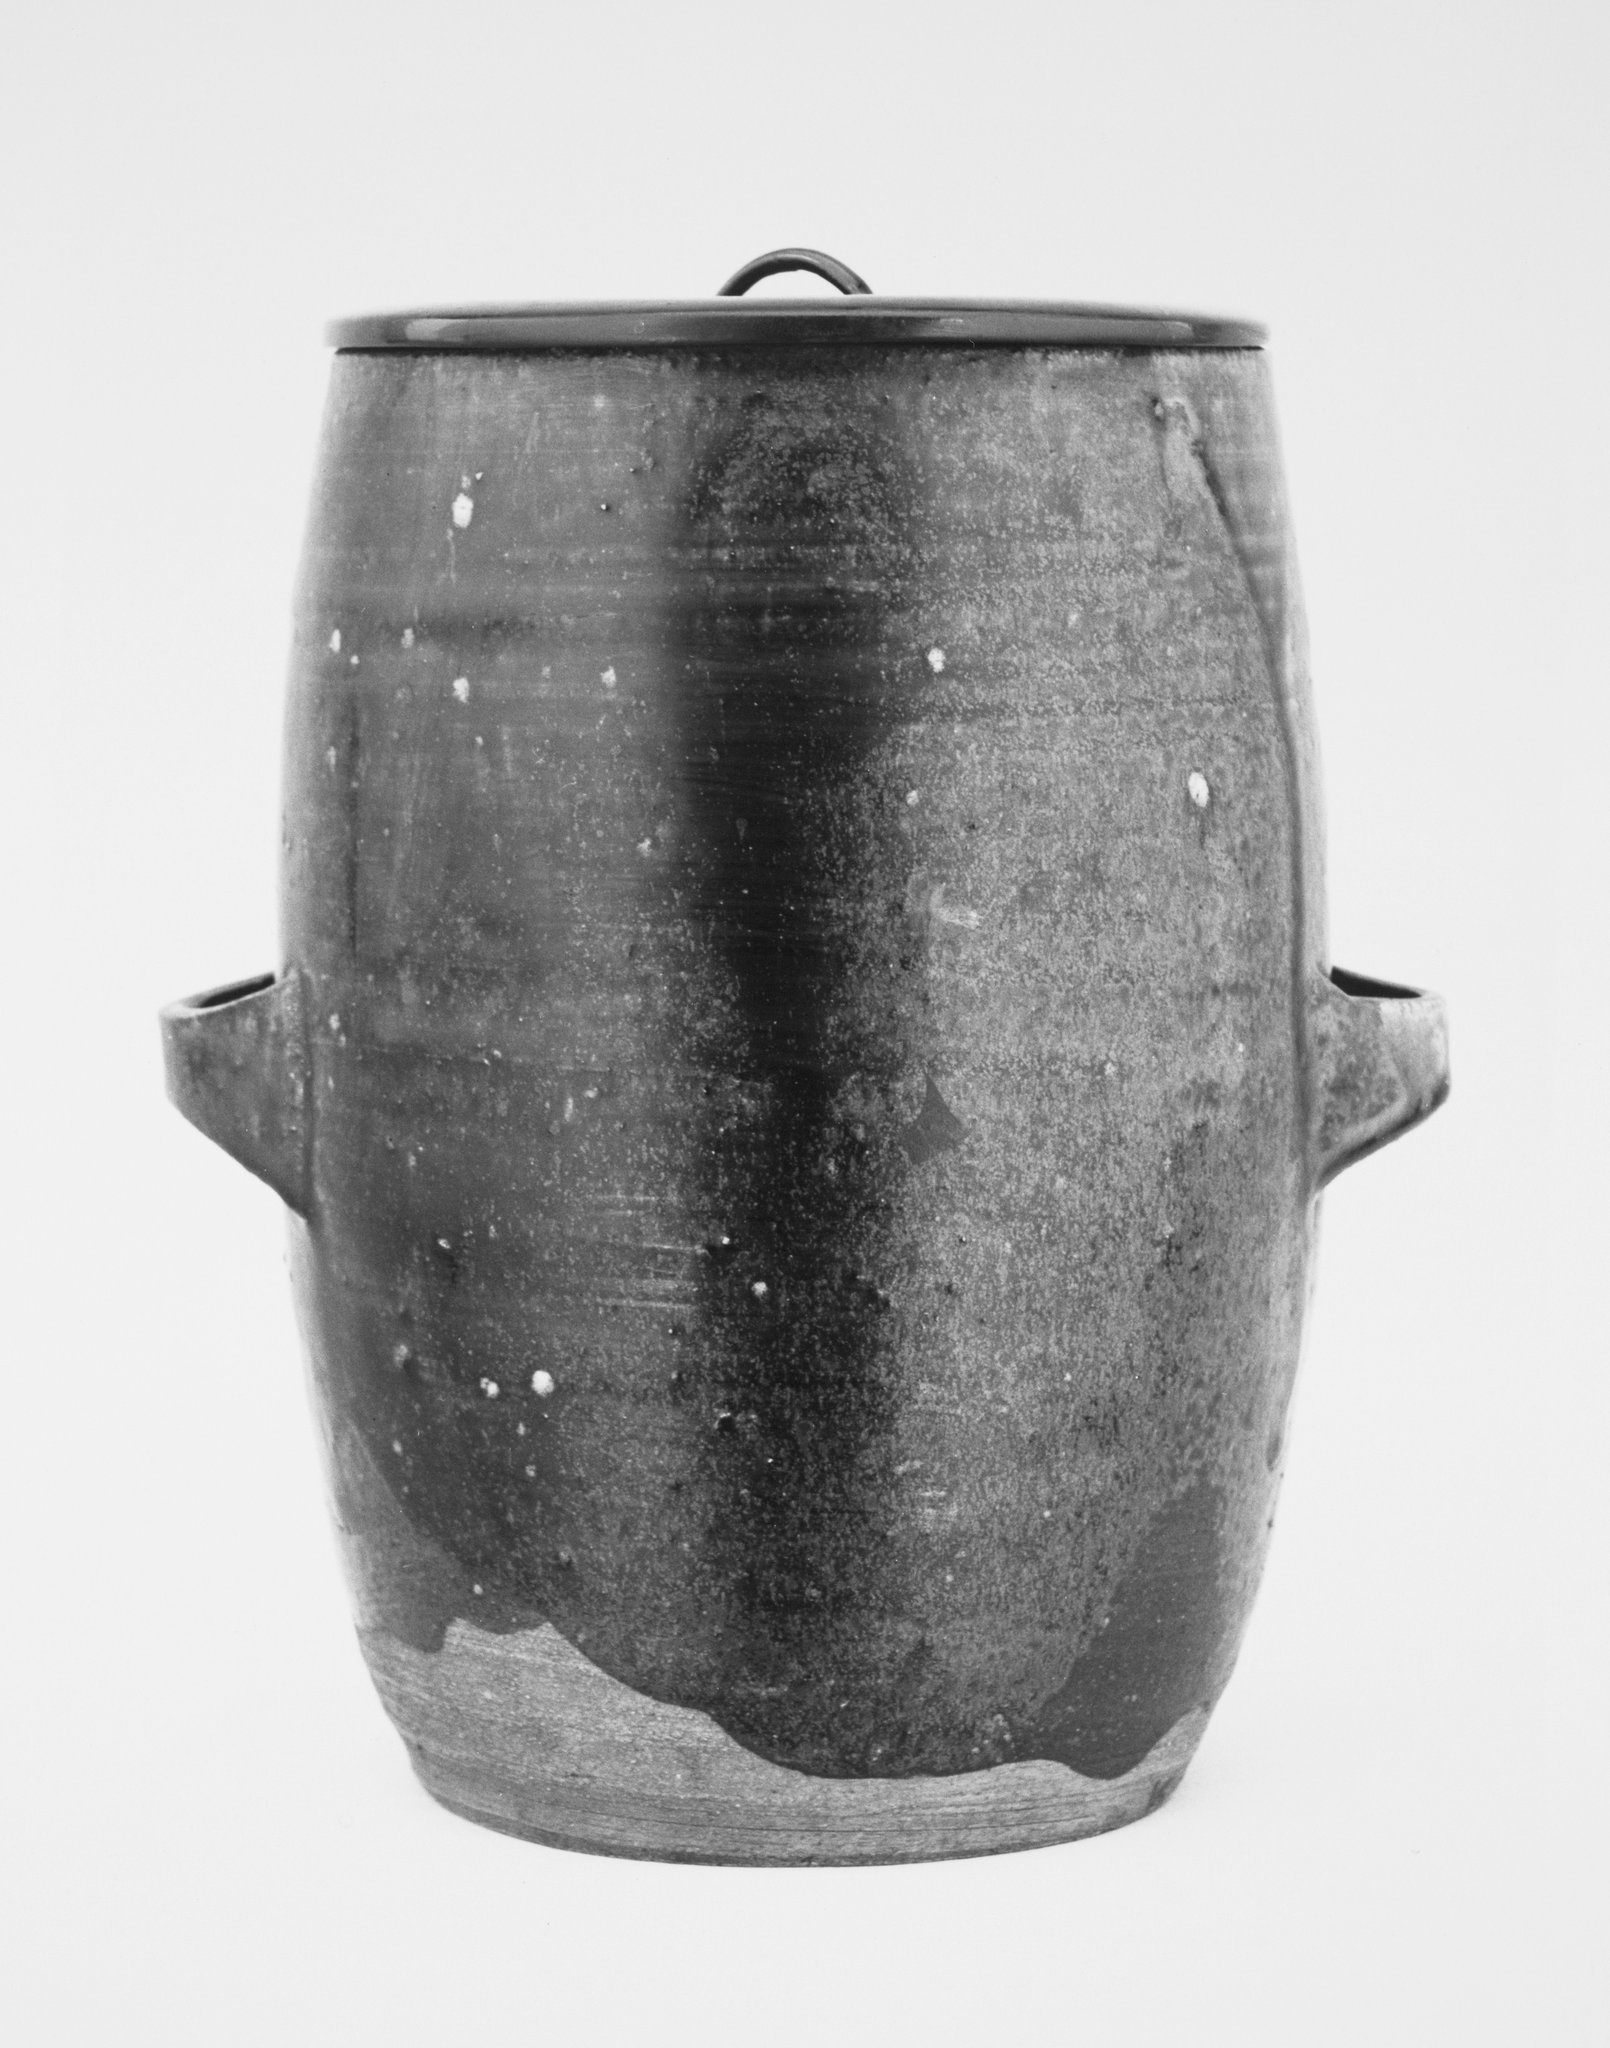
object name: water pot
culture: japanese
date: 1701-1800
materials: clay, glaze